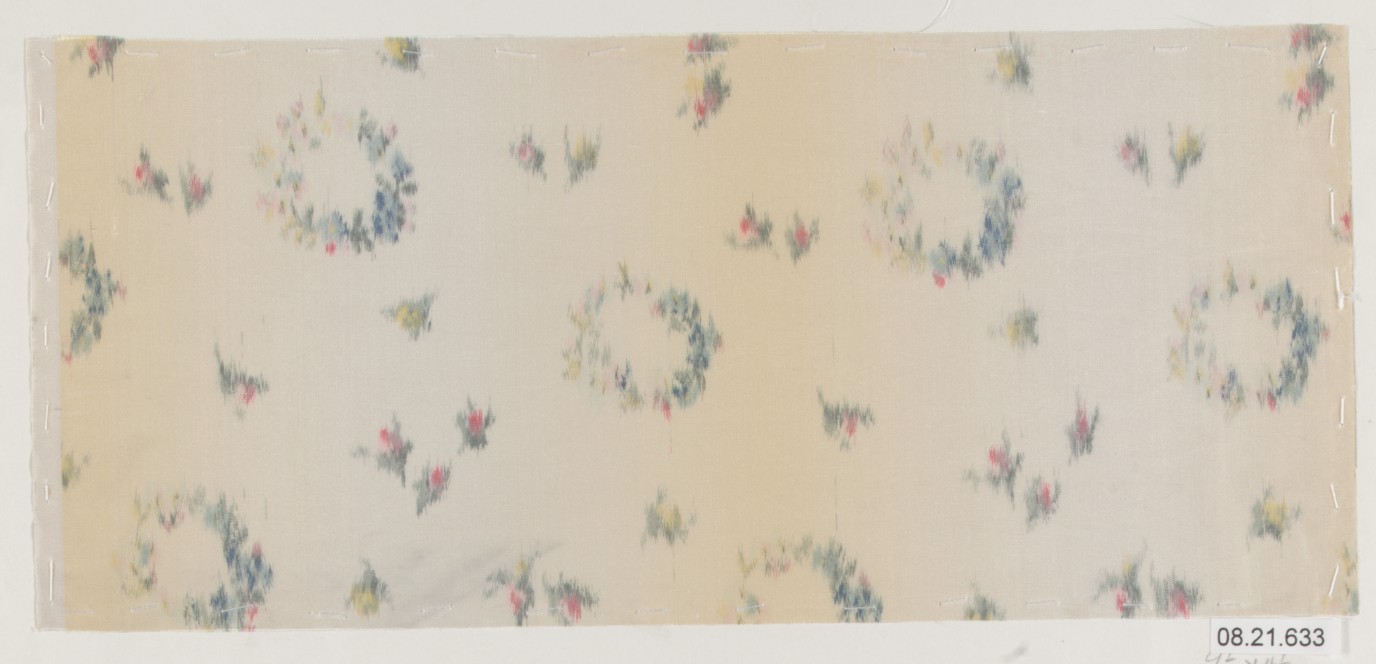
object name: textile sample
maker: Anonymous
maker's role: designer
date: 1900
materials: silk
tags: flowers